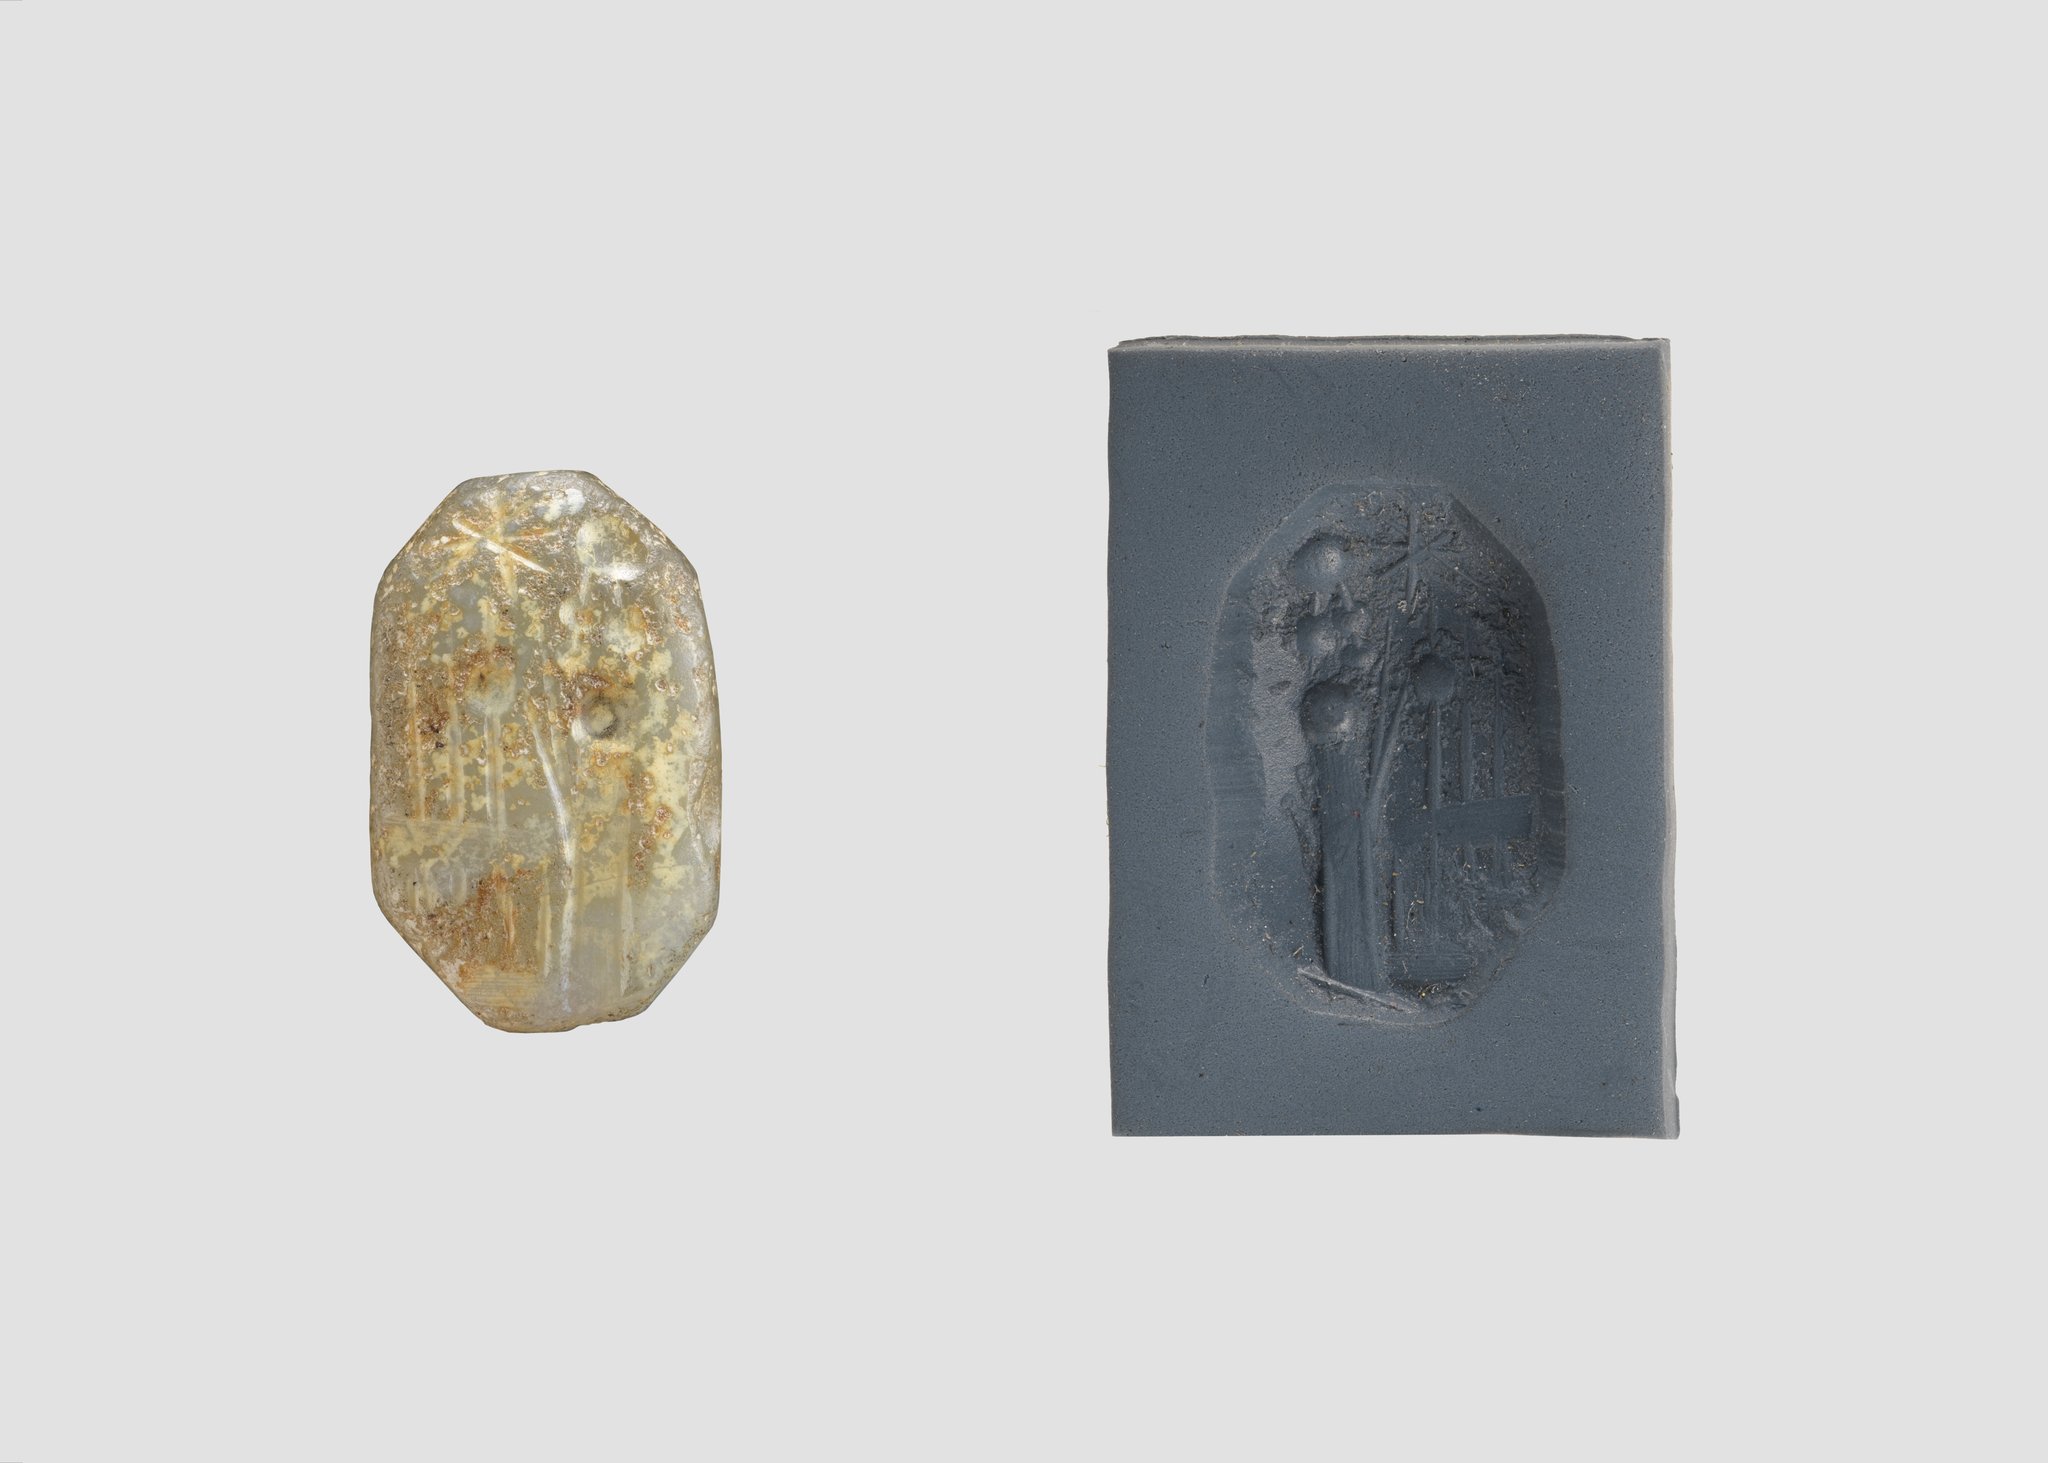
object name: stamp seal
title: Stamp seal (octagonal pyramid) with cultic scene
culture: assyro-babylonian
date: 700-501 BCE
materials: stone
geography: mesopotamia